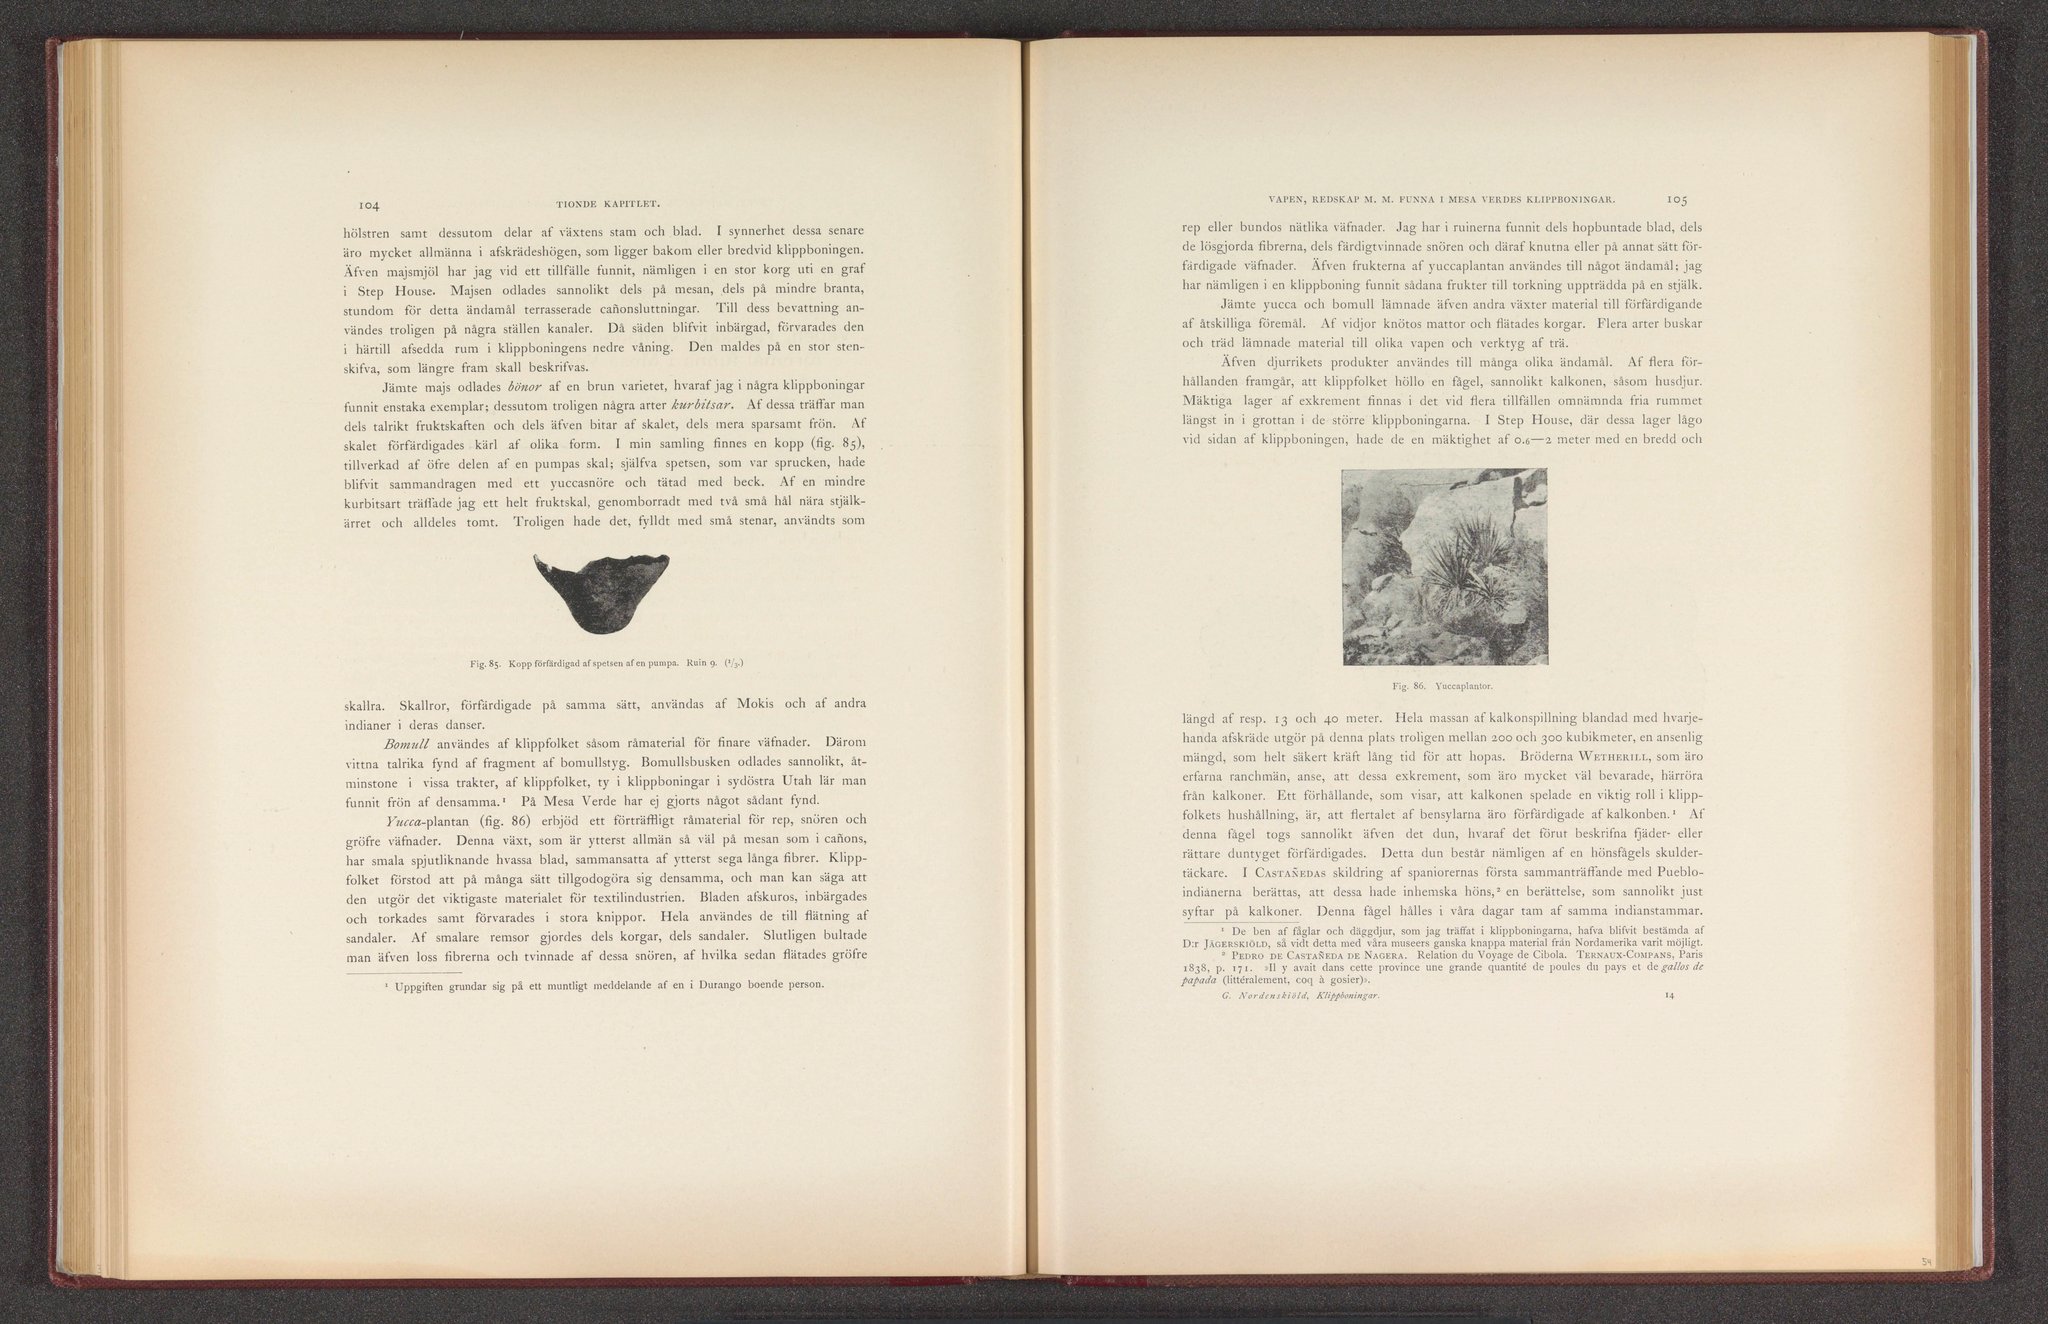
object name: photomechanical print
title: Yucca in het Mesa Verde National Park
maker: gustaf nordenskiöld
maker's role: fotograaf, schrijver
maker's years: 1868-1895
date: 1891-1893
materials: paper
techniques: autotype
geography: vienna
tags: plants; vegetation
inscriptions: number: ‘Fig. 86.’